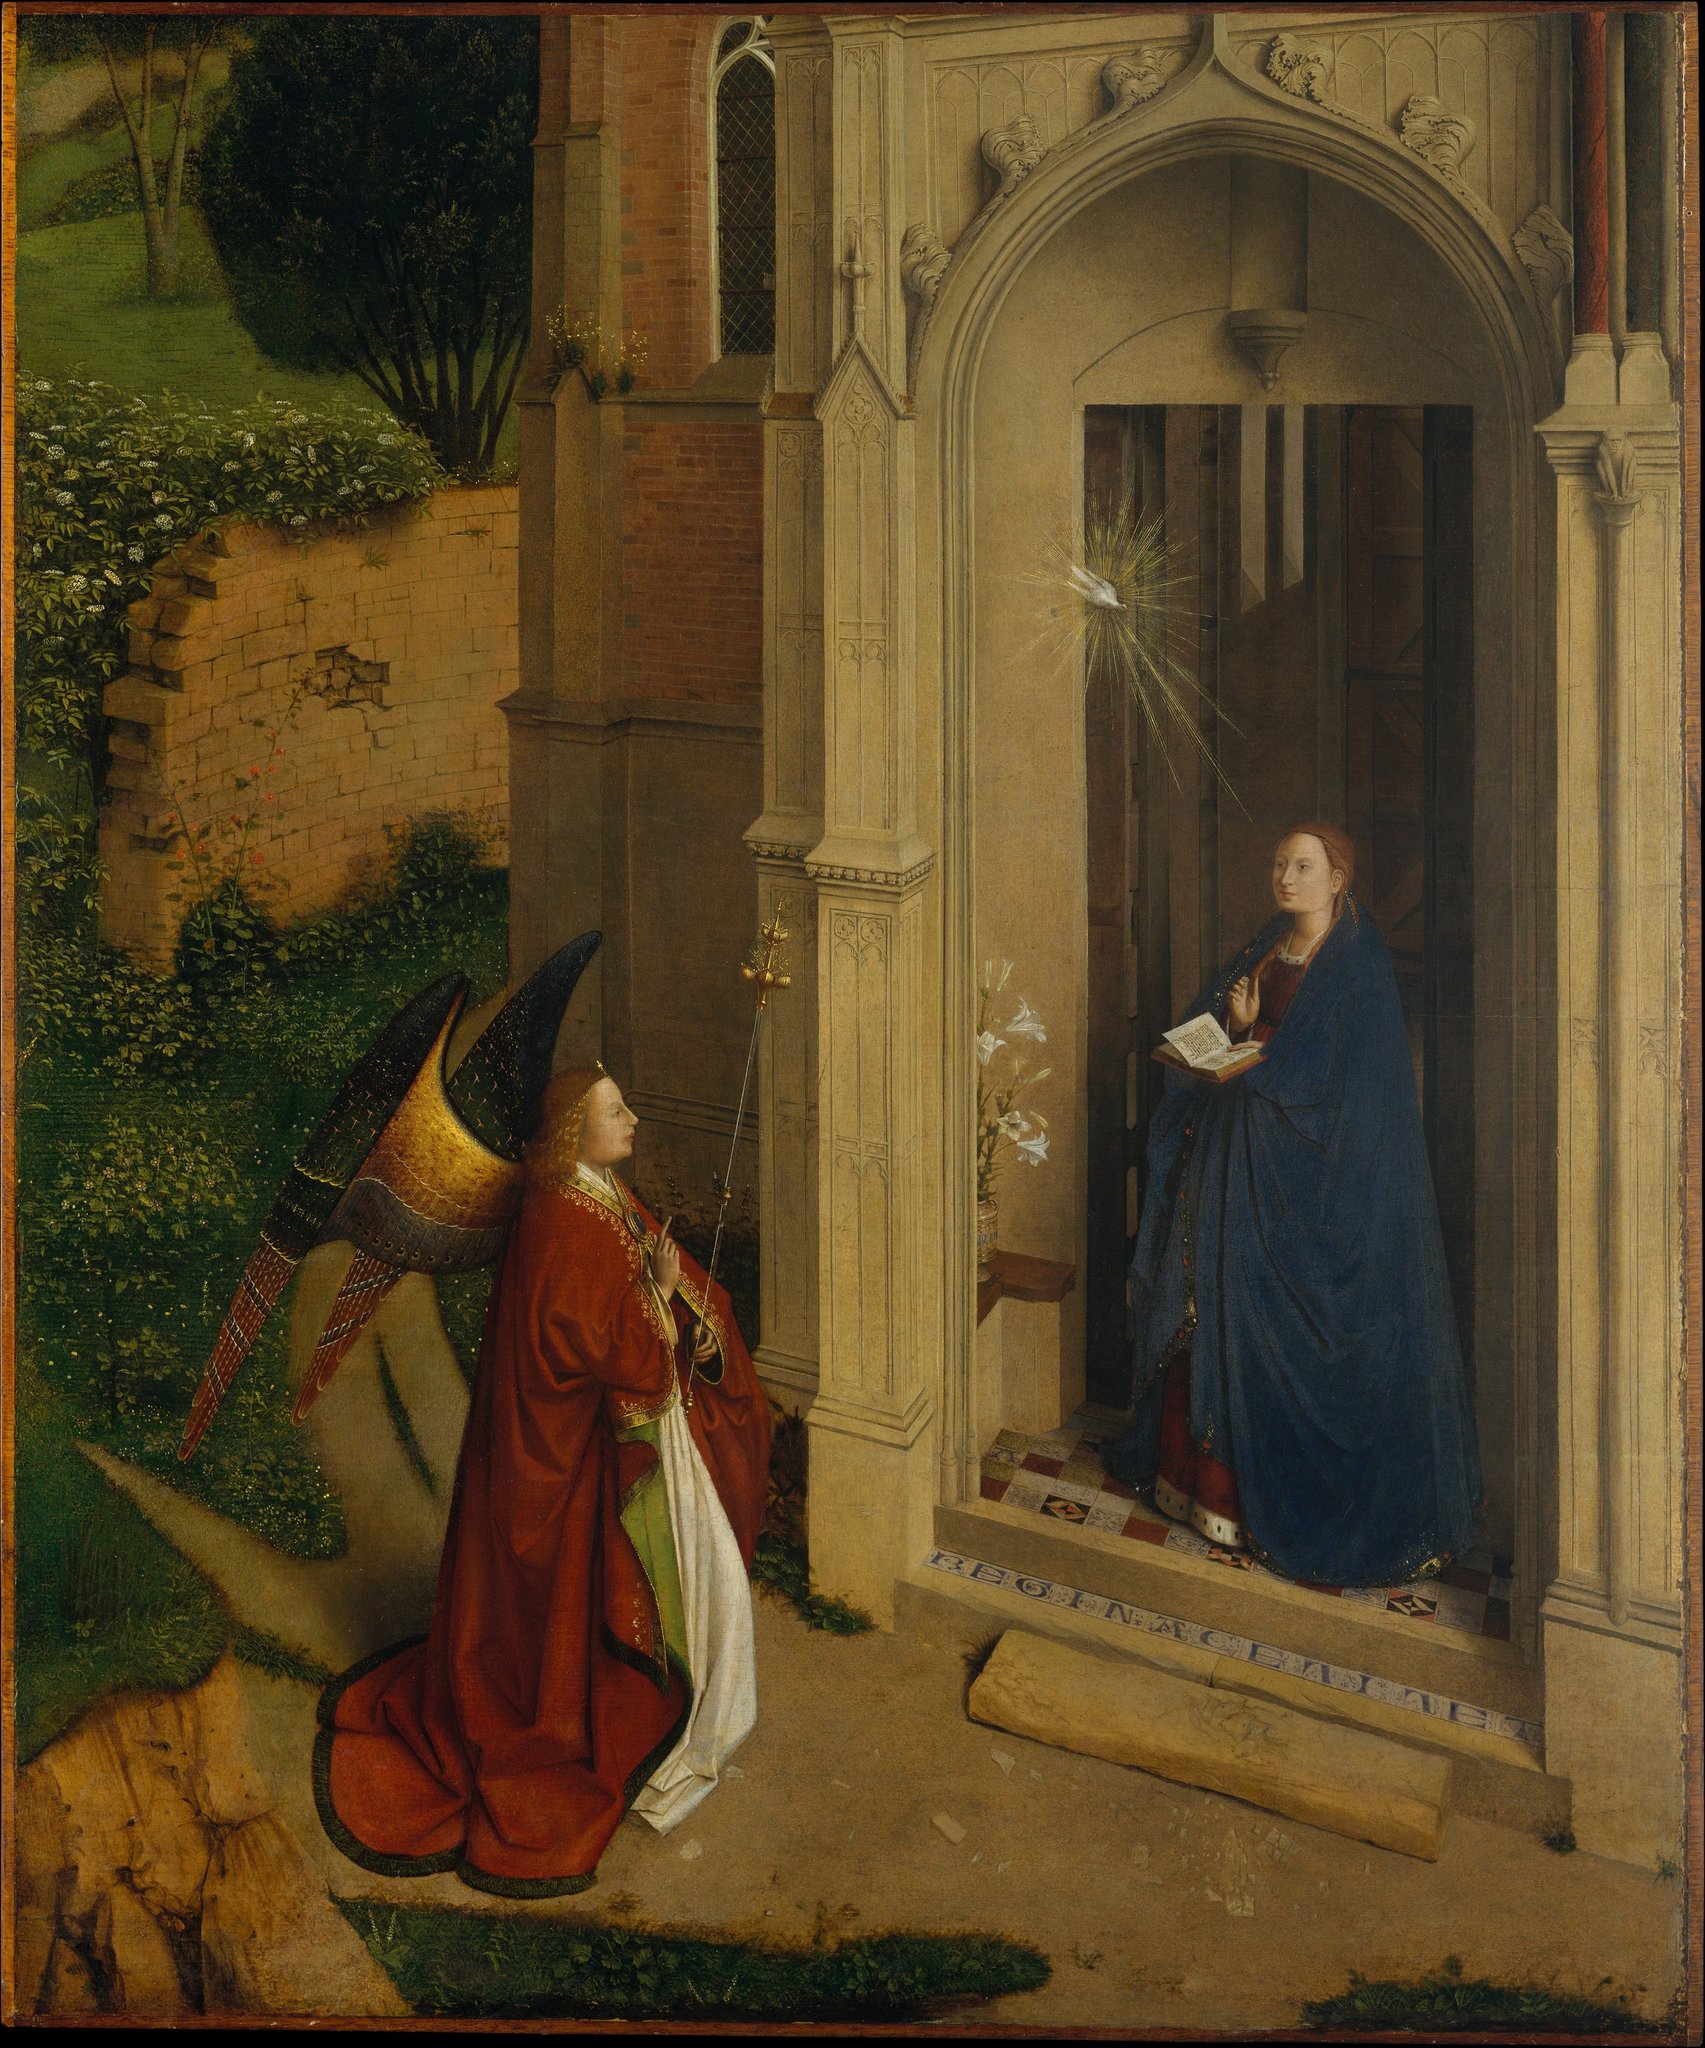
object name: painting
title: The Annunciation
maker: petrus christus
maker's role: artist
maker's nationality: netherlandish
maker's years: 1444-1476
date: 1445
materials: oil, wood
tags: doves,lilies,virgin mary,archangel gabriel,annunciation